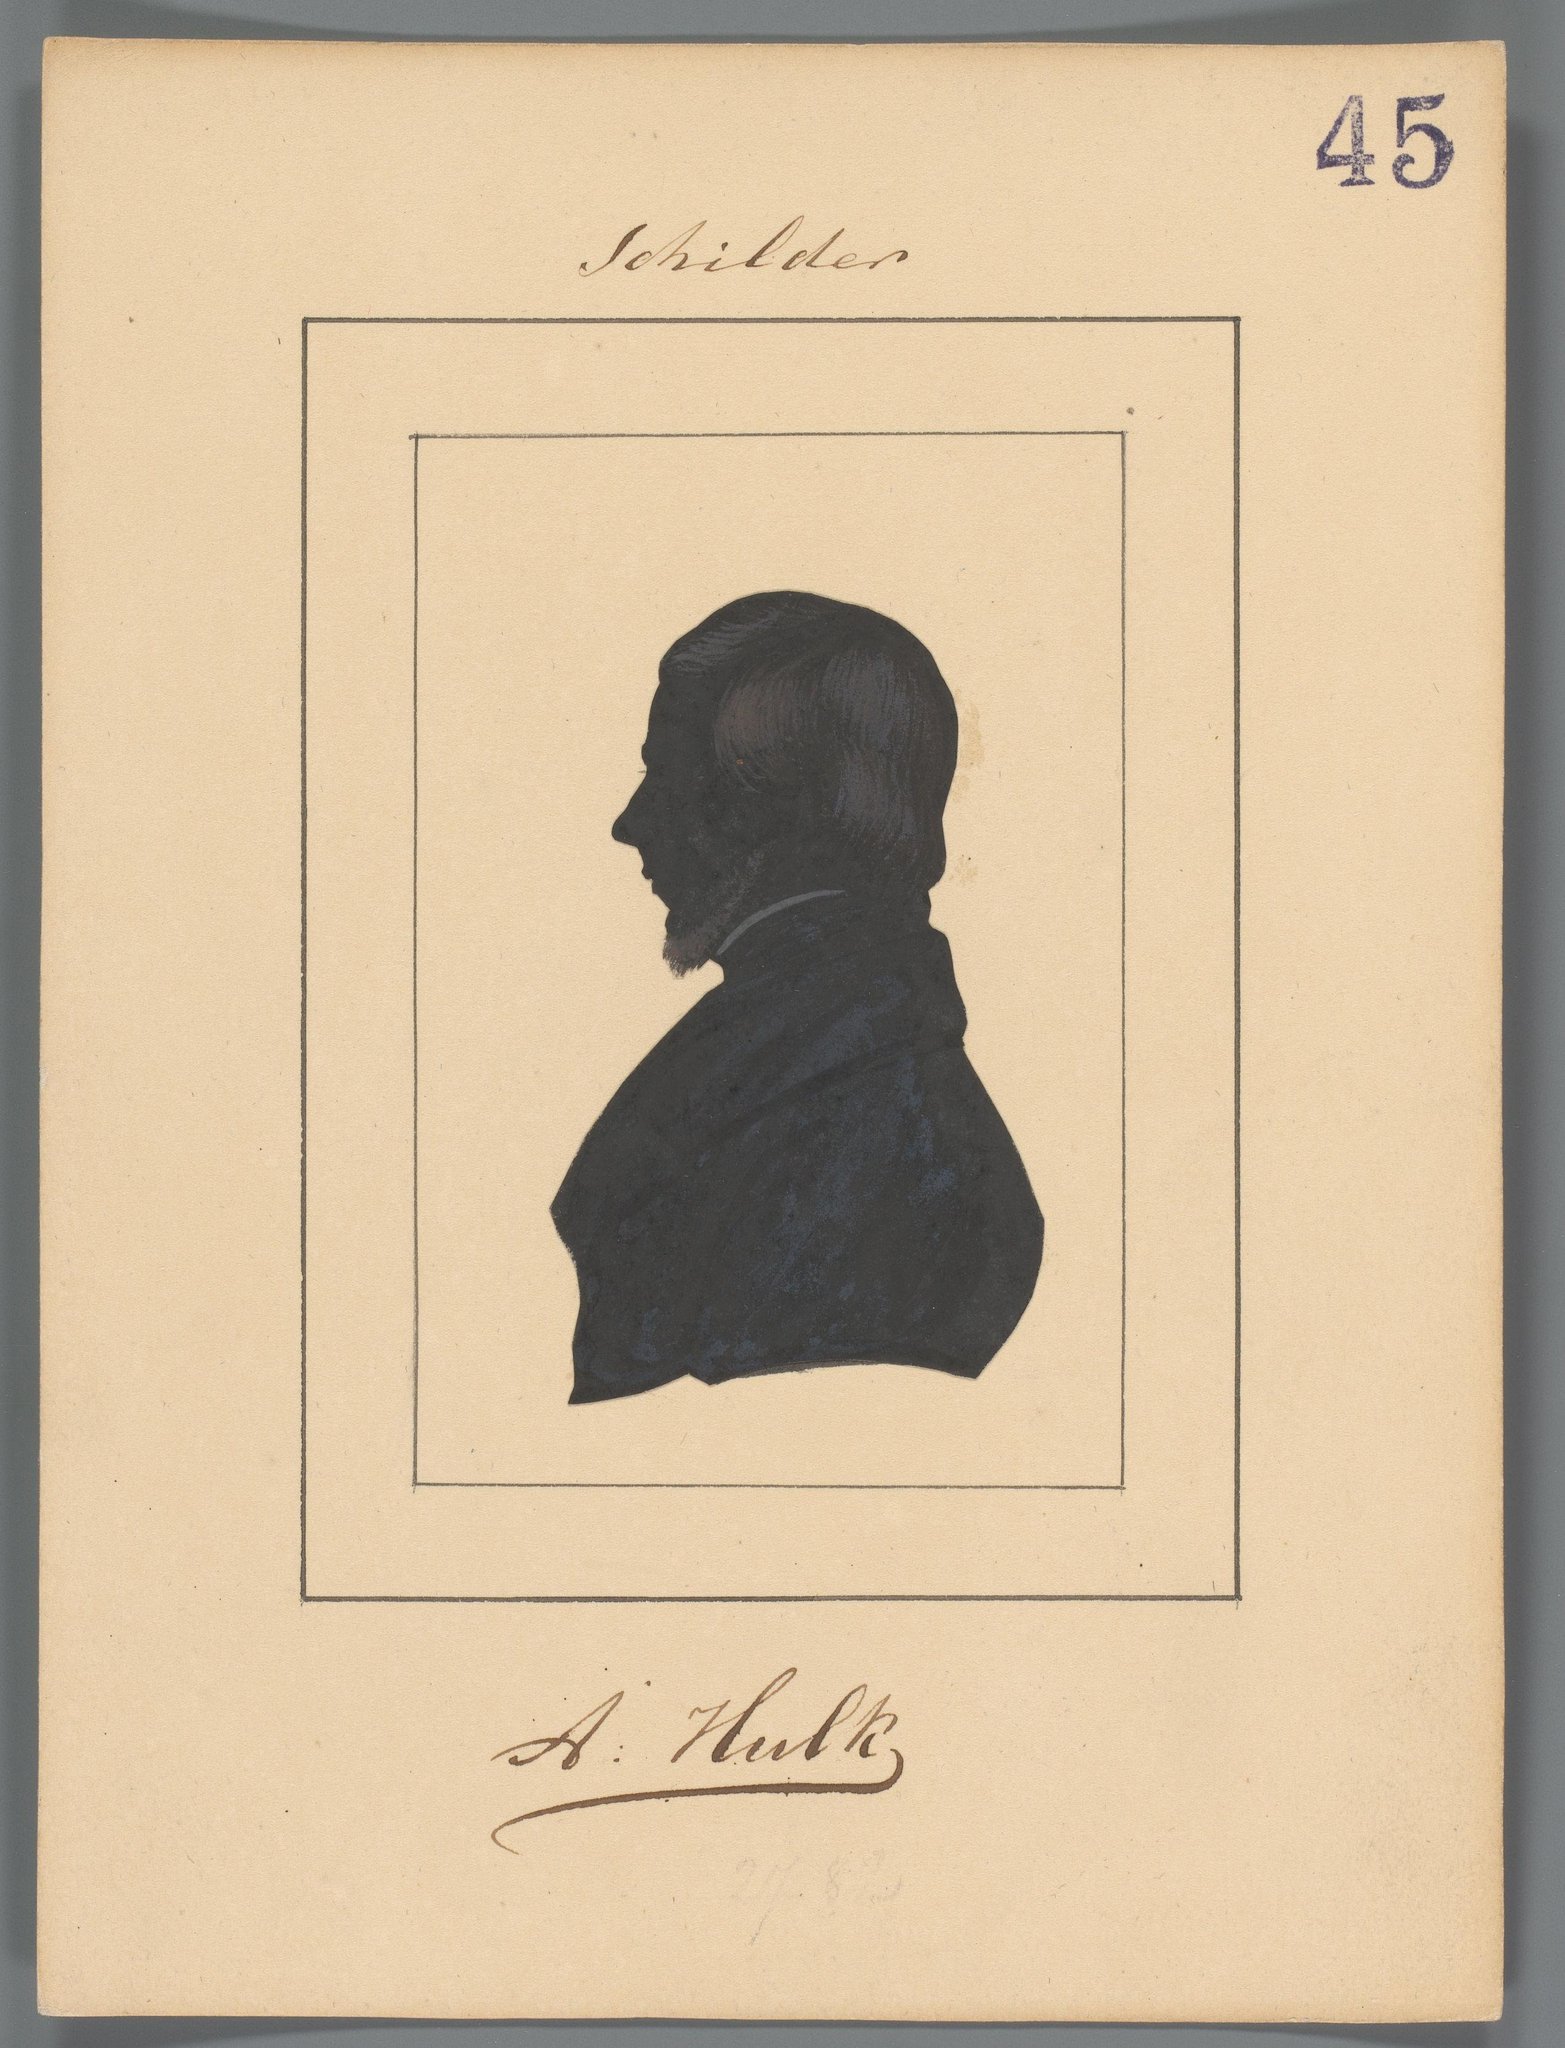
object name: drawing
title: Silhouetportret van Abraham Hulk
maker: elisabeth alida haanen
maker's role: draughtsman, print maker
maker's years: 1809-1845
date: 1819-1845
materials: ink, paint, paper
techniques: brush, snipping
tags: london, painter, abraham hulk, historical persons, portrait, self-portrait of painter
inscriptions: collector's mark: ‘Ex-libris van Beresteyn’, inscription: ‘Neg. D. 1761’, number: ‘13952’, inscription: ‘Schilder’, inscription: ‘A: Hulk’, number: ‘45’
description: Met onder het portret de handtekening van de geportretteerde.